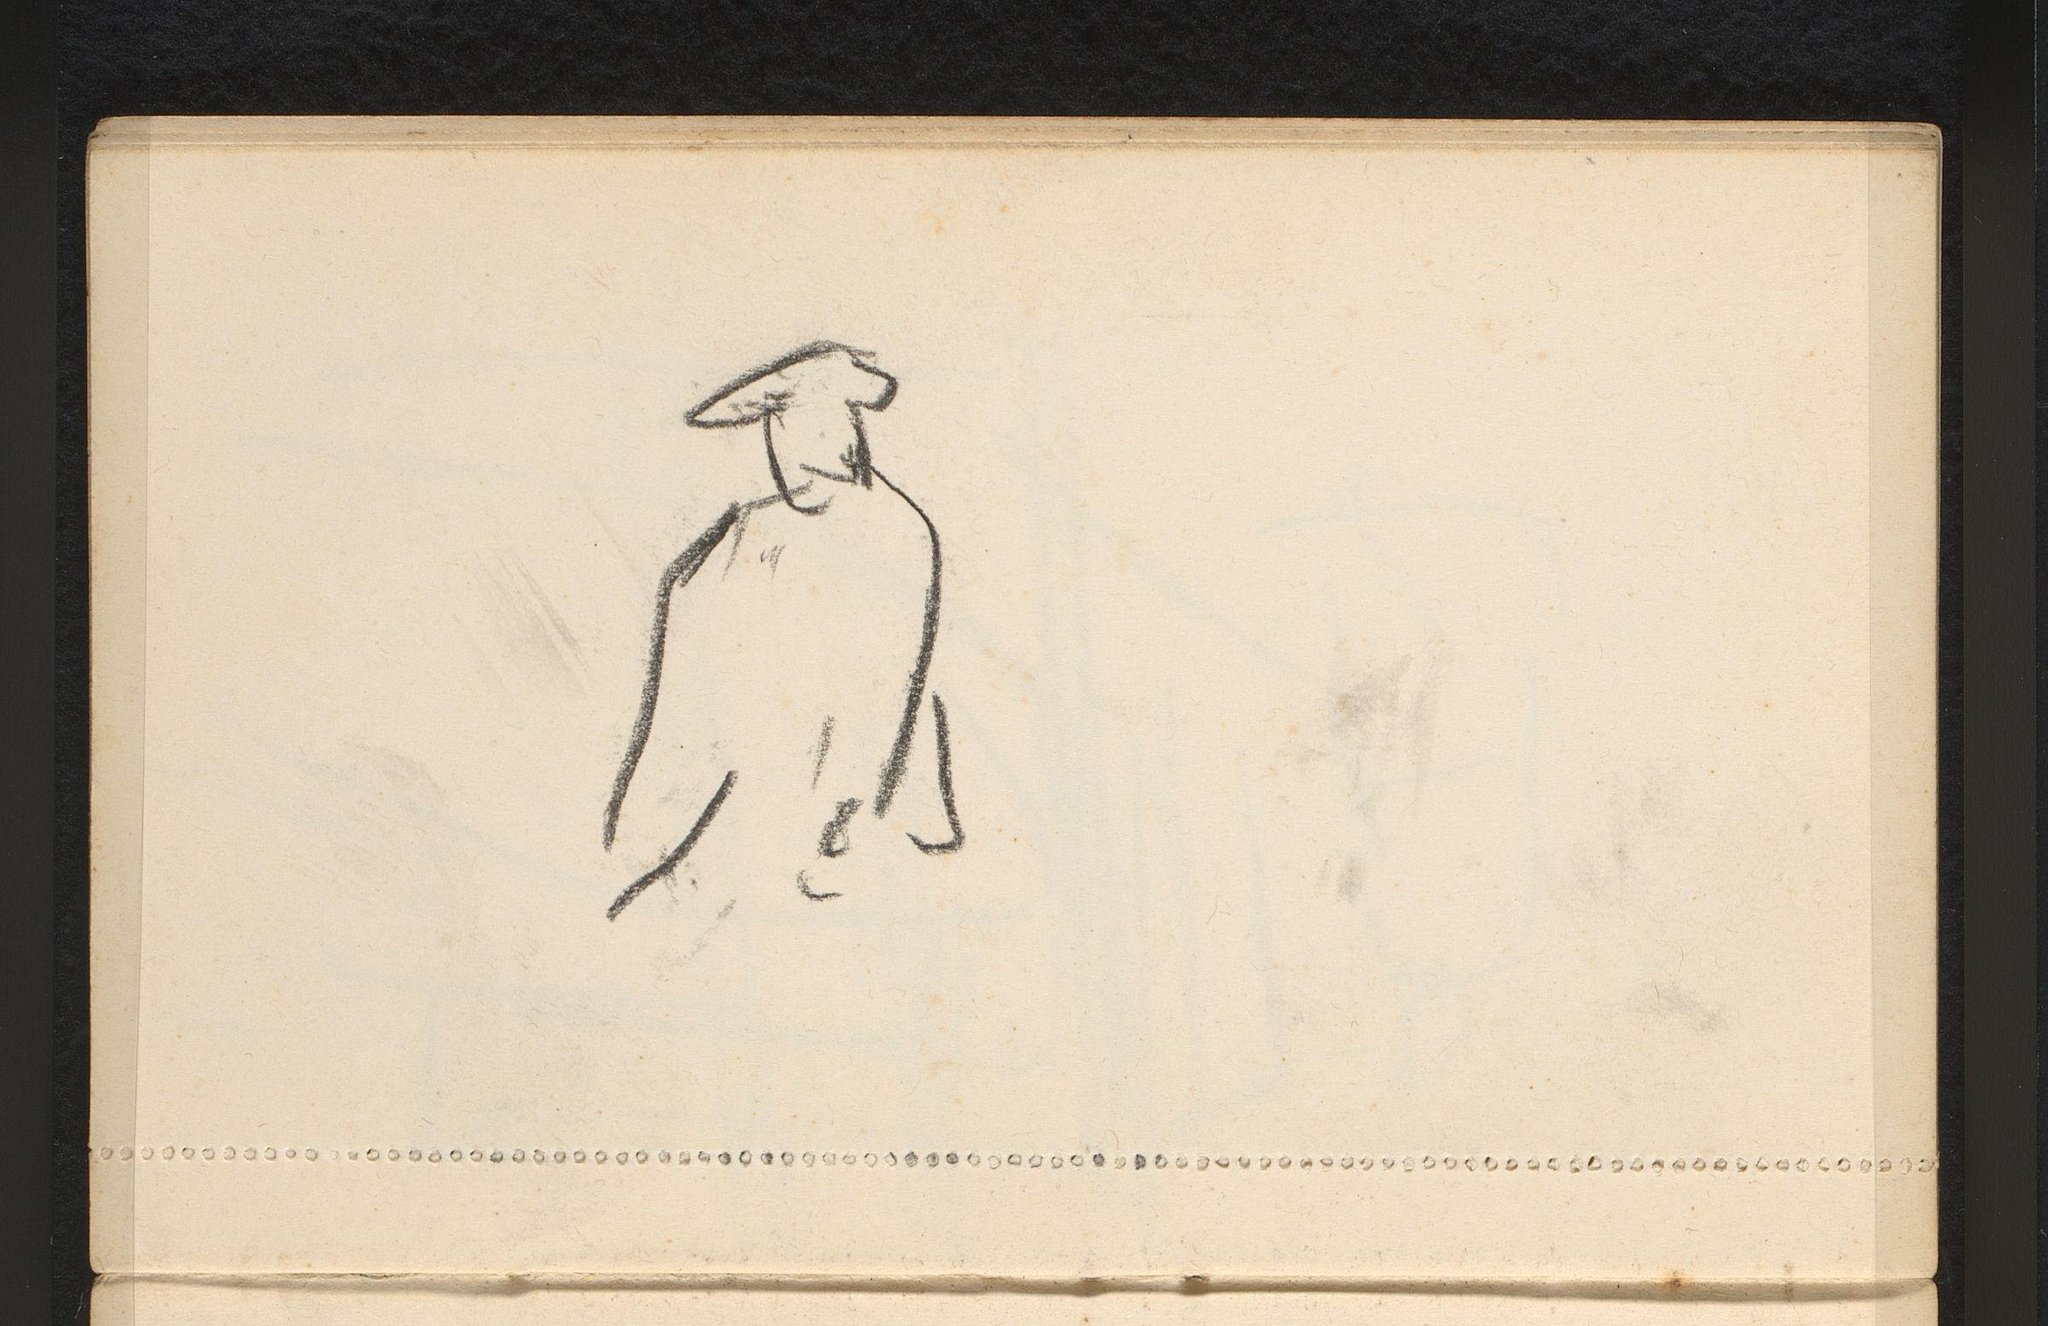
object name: sketchbook leaf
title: Bovenlichaam van een man met pet, vermoedelijk een visser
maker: gerrit van blaaderen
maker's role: draughtsman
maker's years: 1873-1935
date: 1908-1927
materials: chalk, paper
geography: france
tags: head-gear: cap, fisherman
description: Blad 18 verso uit een schetsboek met 33 bladen.